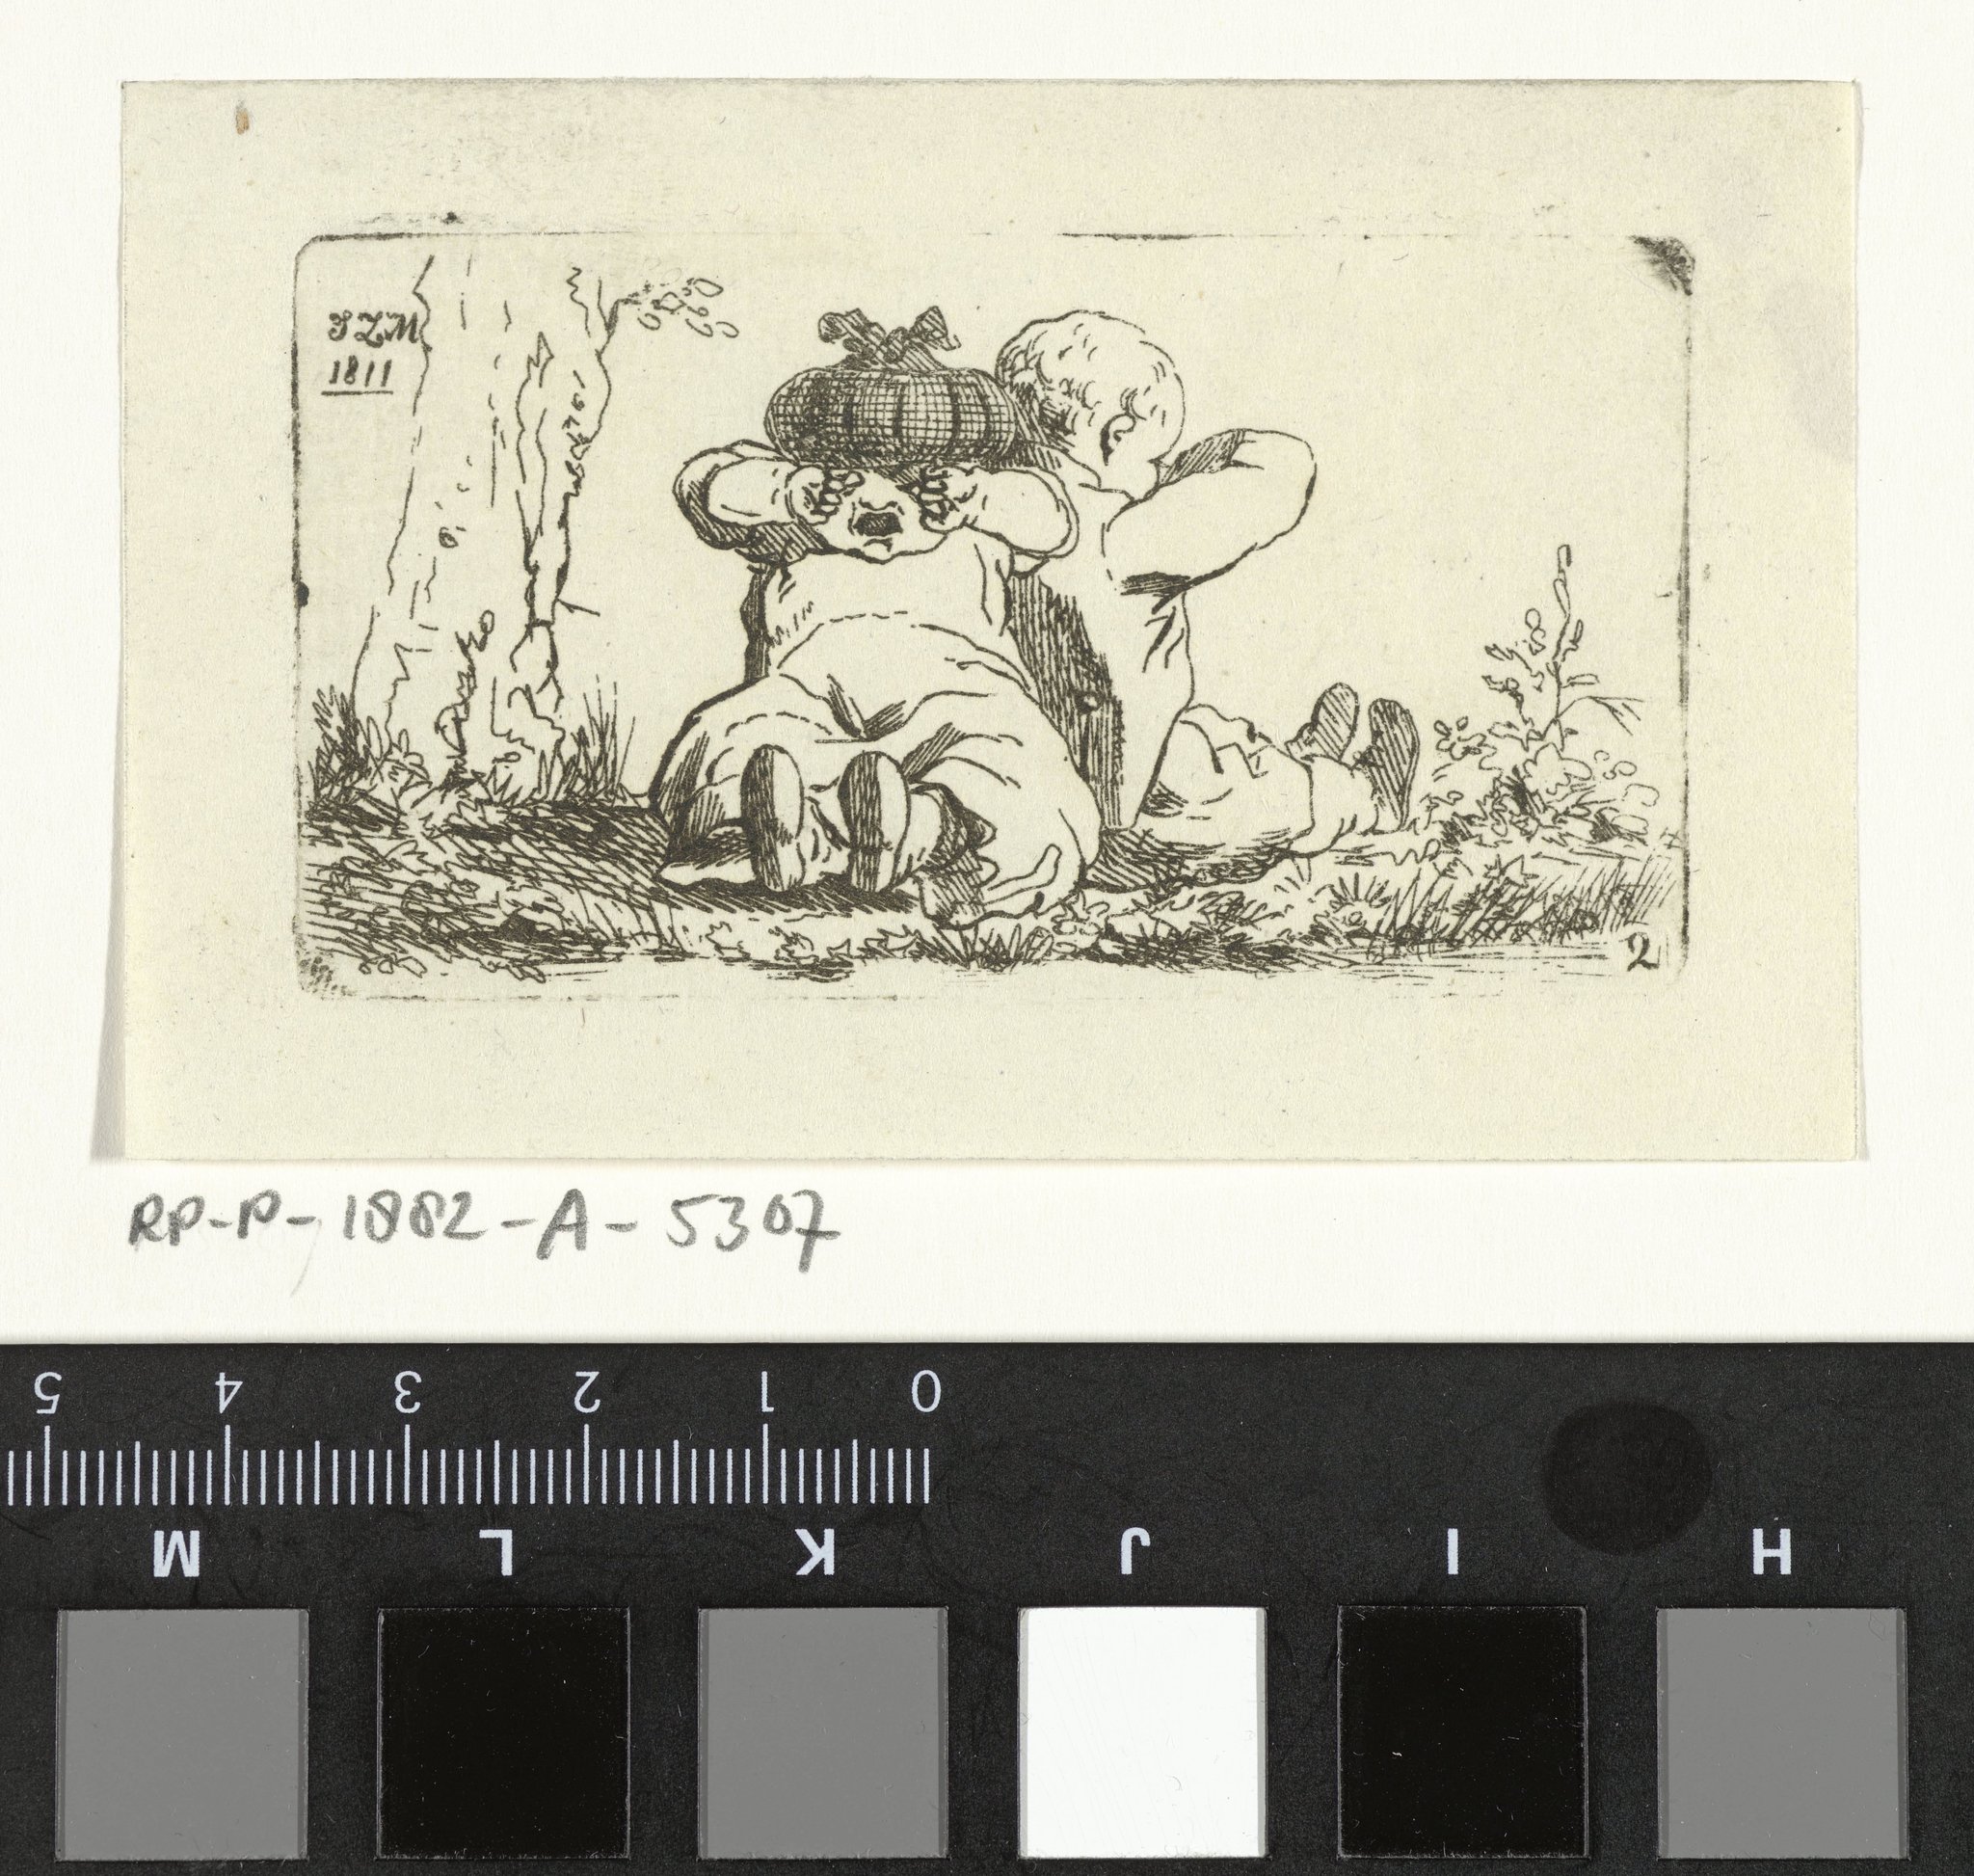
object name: print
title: Twee huilende kinderen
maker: jean zacherie mazel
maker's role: draughtsman, print maker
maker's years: 1792-1884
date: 1811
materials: paper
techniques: etching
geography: netherlands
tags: child, weeping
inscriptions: collector's mark: Lugt 2228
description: Een meisje en een jongen zitten met de rug tegen elkaar in het gras. Zij wrijven beiden in hun ogen.